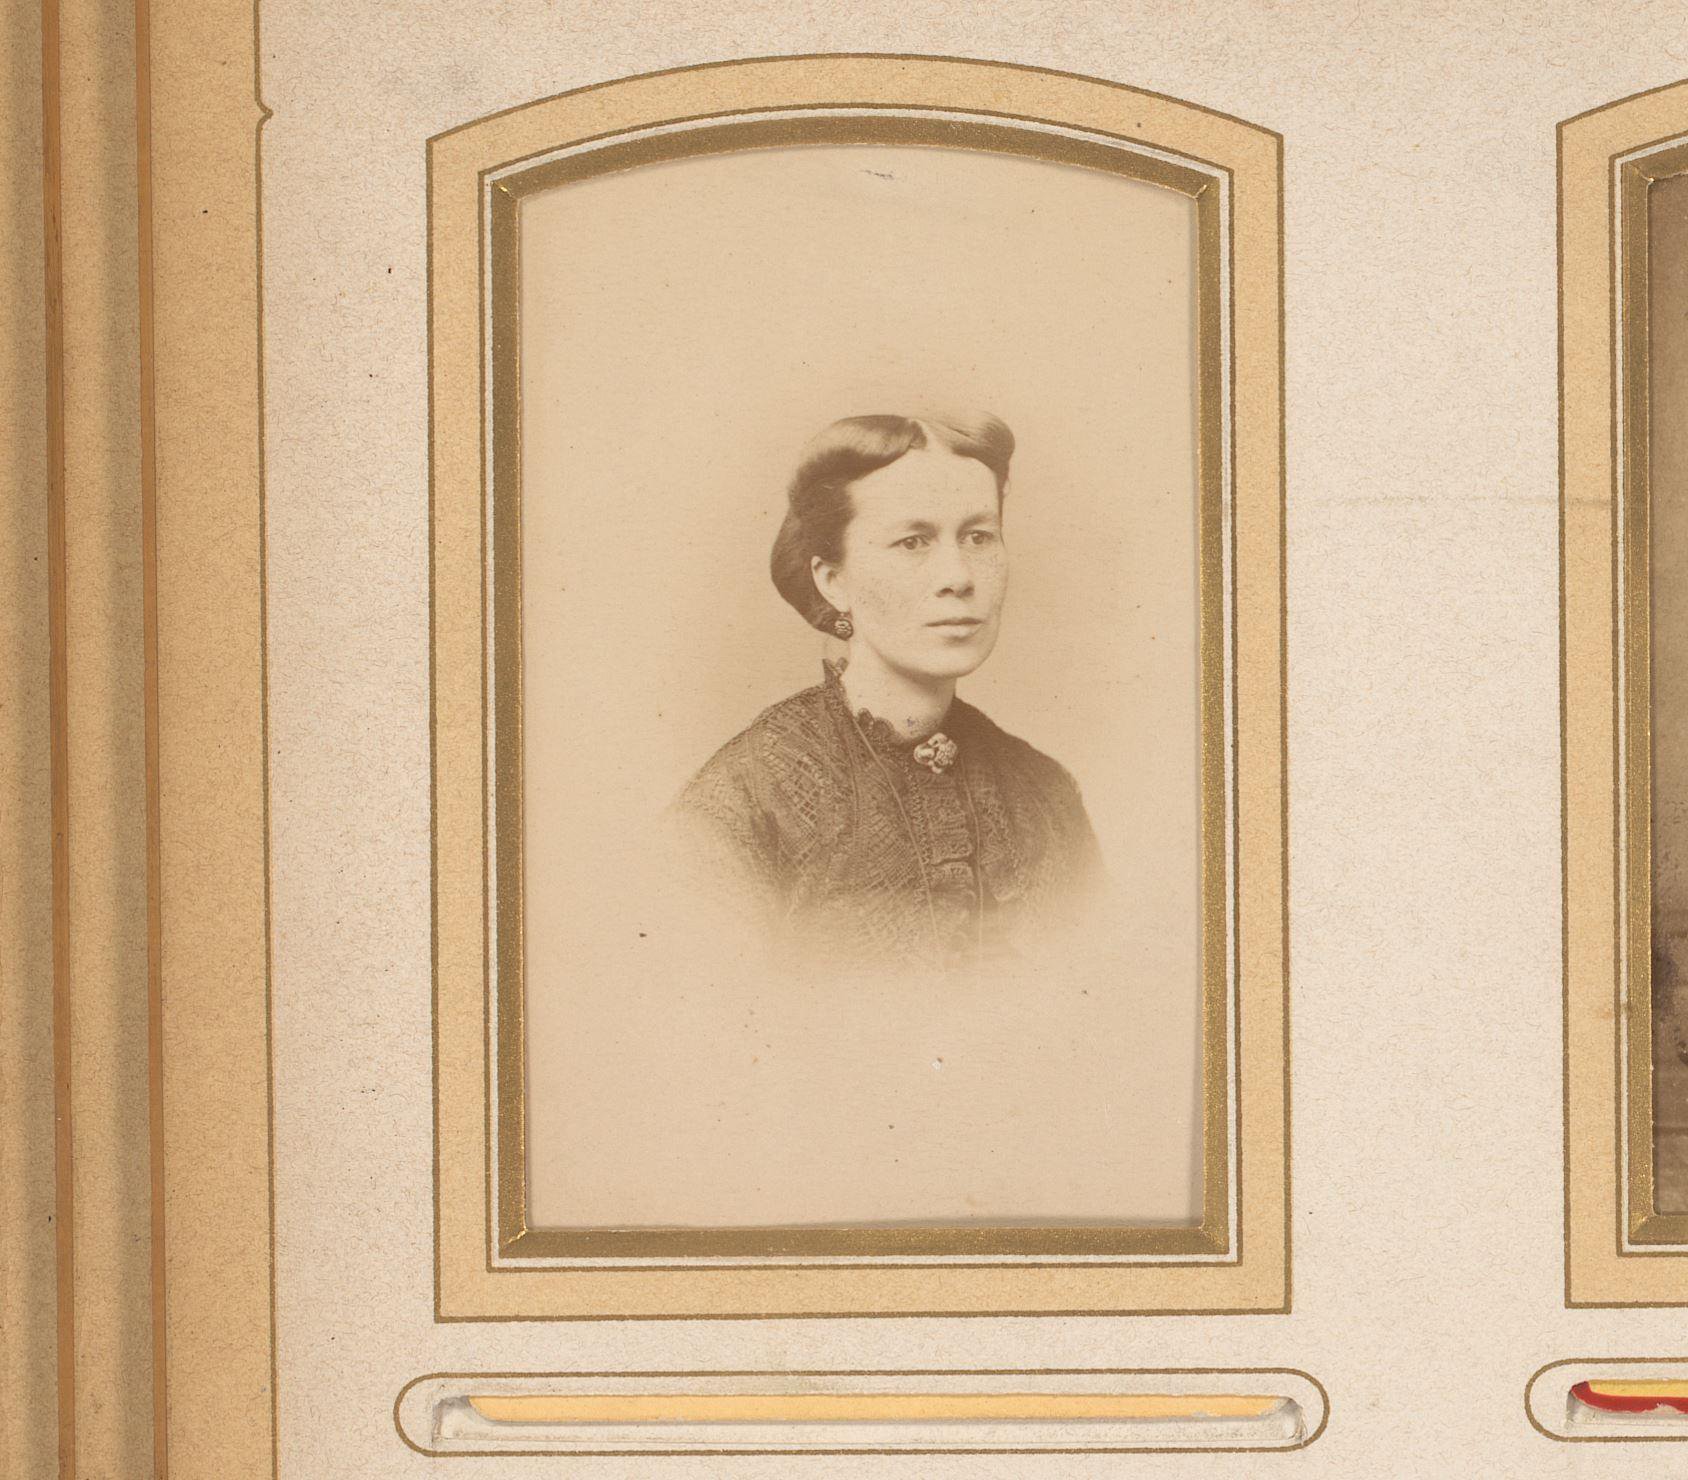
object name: carte de visite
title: Portret van een vrouw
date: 1860-1900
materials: cardboard, photographic support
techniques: albumen print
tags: adult woman, historical persons